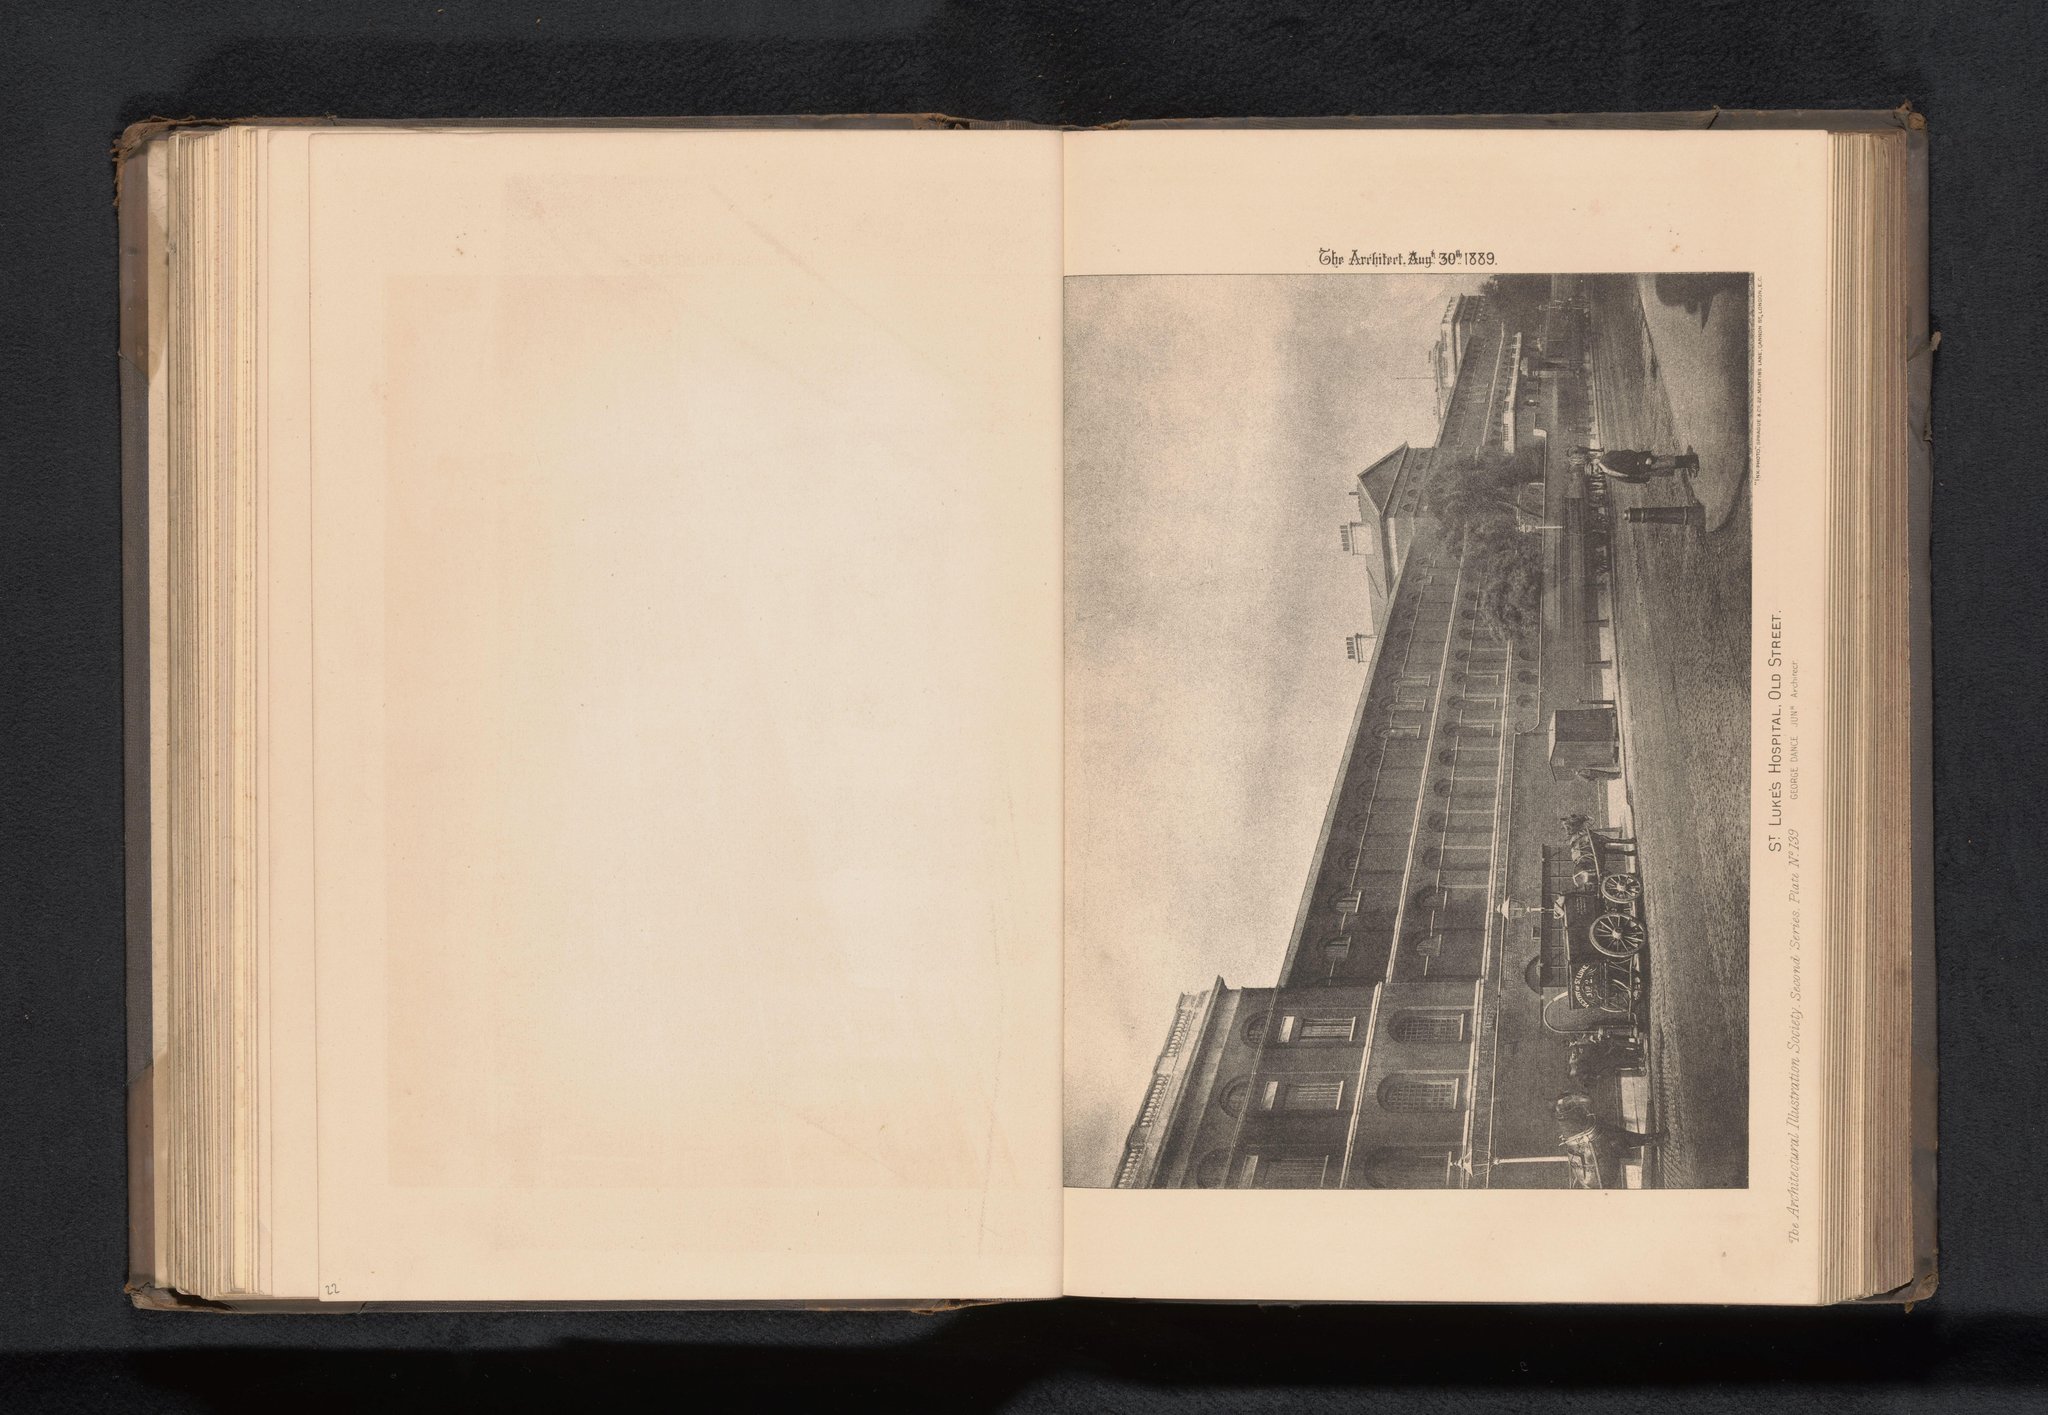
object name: page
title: St. Luke's Hospital, Old Street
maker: Anonymous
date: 1884-1889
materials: paper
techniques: photolithography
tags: hospital, street (+ city(-scape) with figures, staffage), london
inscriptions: inscription: ‘George Dance Junr. Architect/ The Architectural Illustration Society. Second Series. Plate No.139’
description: Prent op elfde ongenummerde pagina na pagina 120.